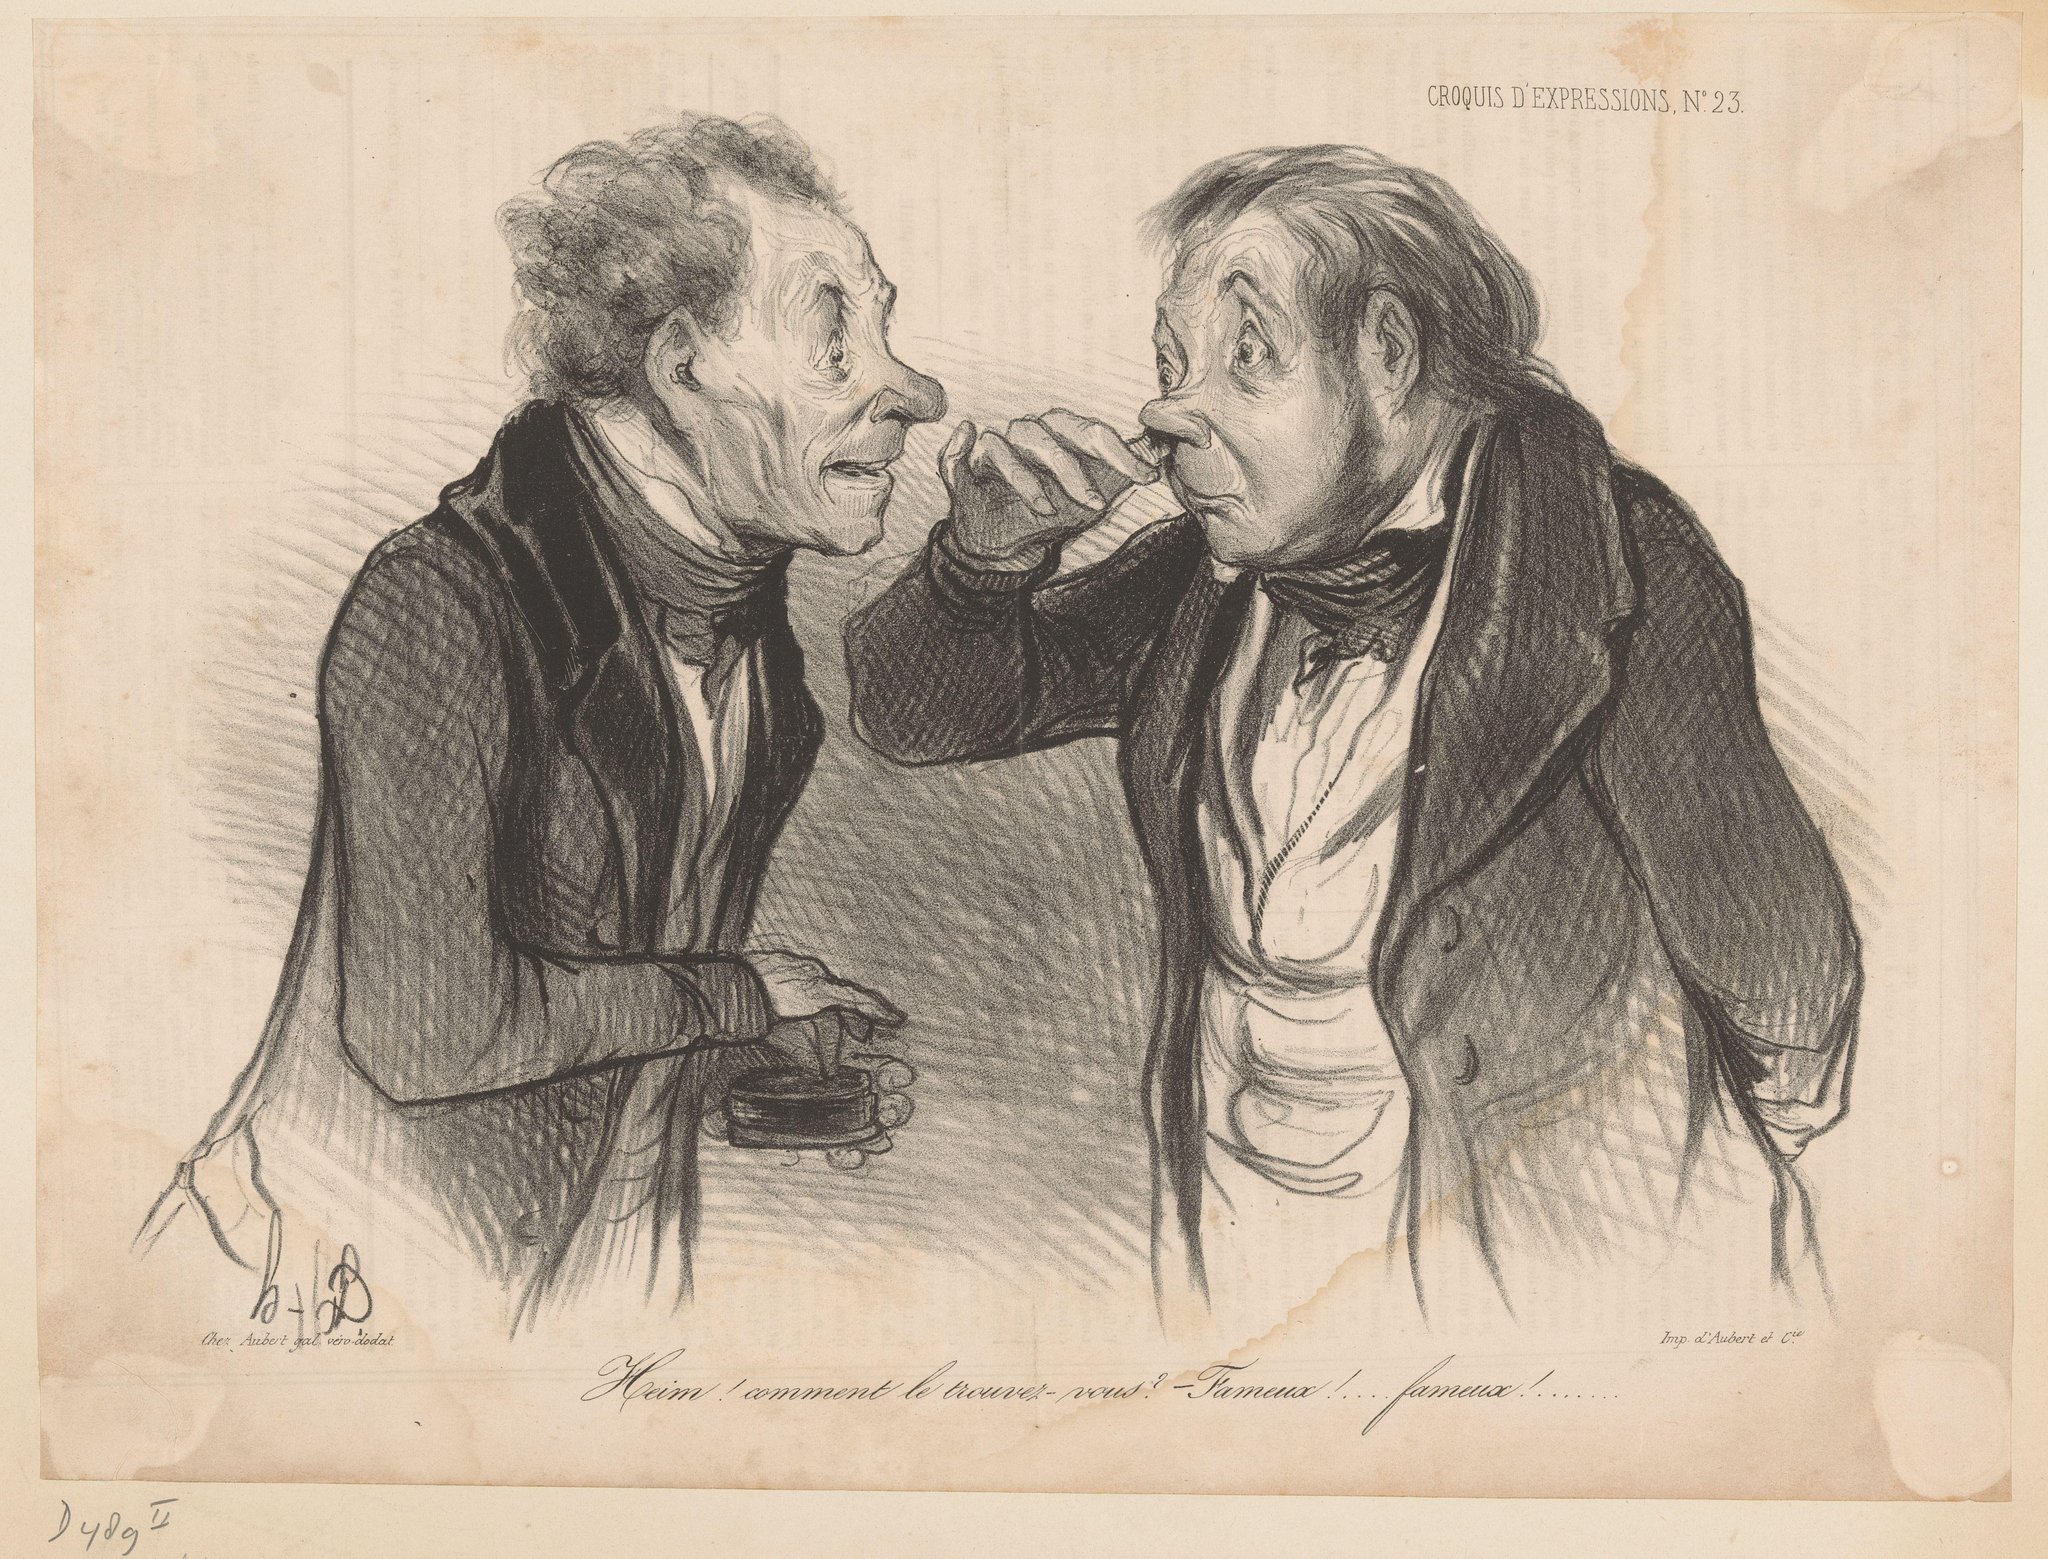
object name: cartoon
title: Croquis d'expressions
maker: honoré daumier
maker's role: draughtsman, painter, print maker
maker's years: 1808-1879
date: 1838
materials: paper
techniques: letterpress printing, lithograph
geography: paris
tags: caricatures (human types), snuff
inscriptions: collector's mark: Lugt 2228a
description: Prent mogelijk uit: Le Charivari, 30 augustus 1838.